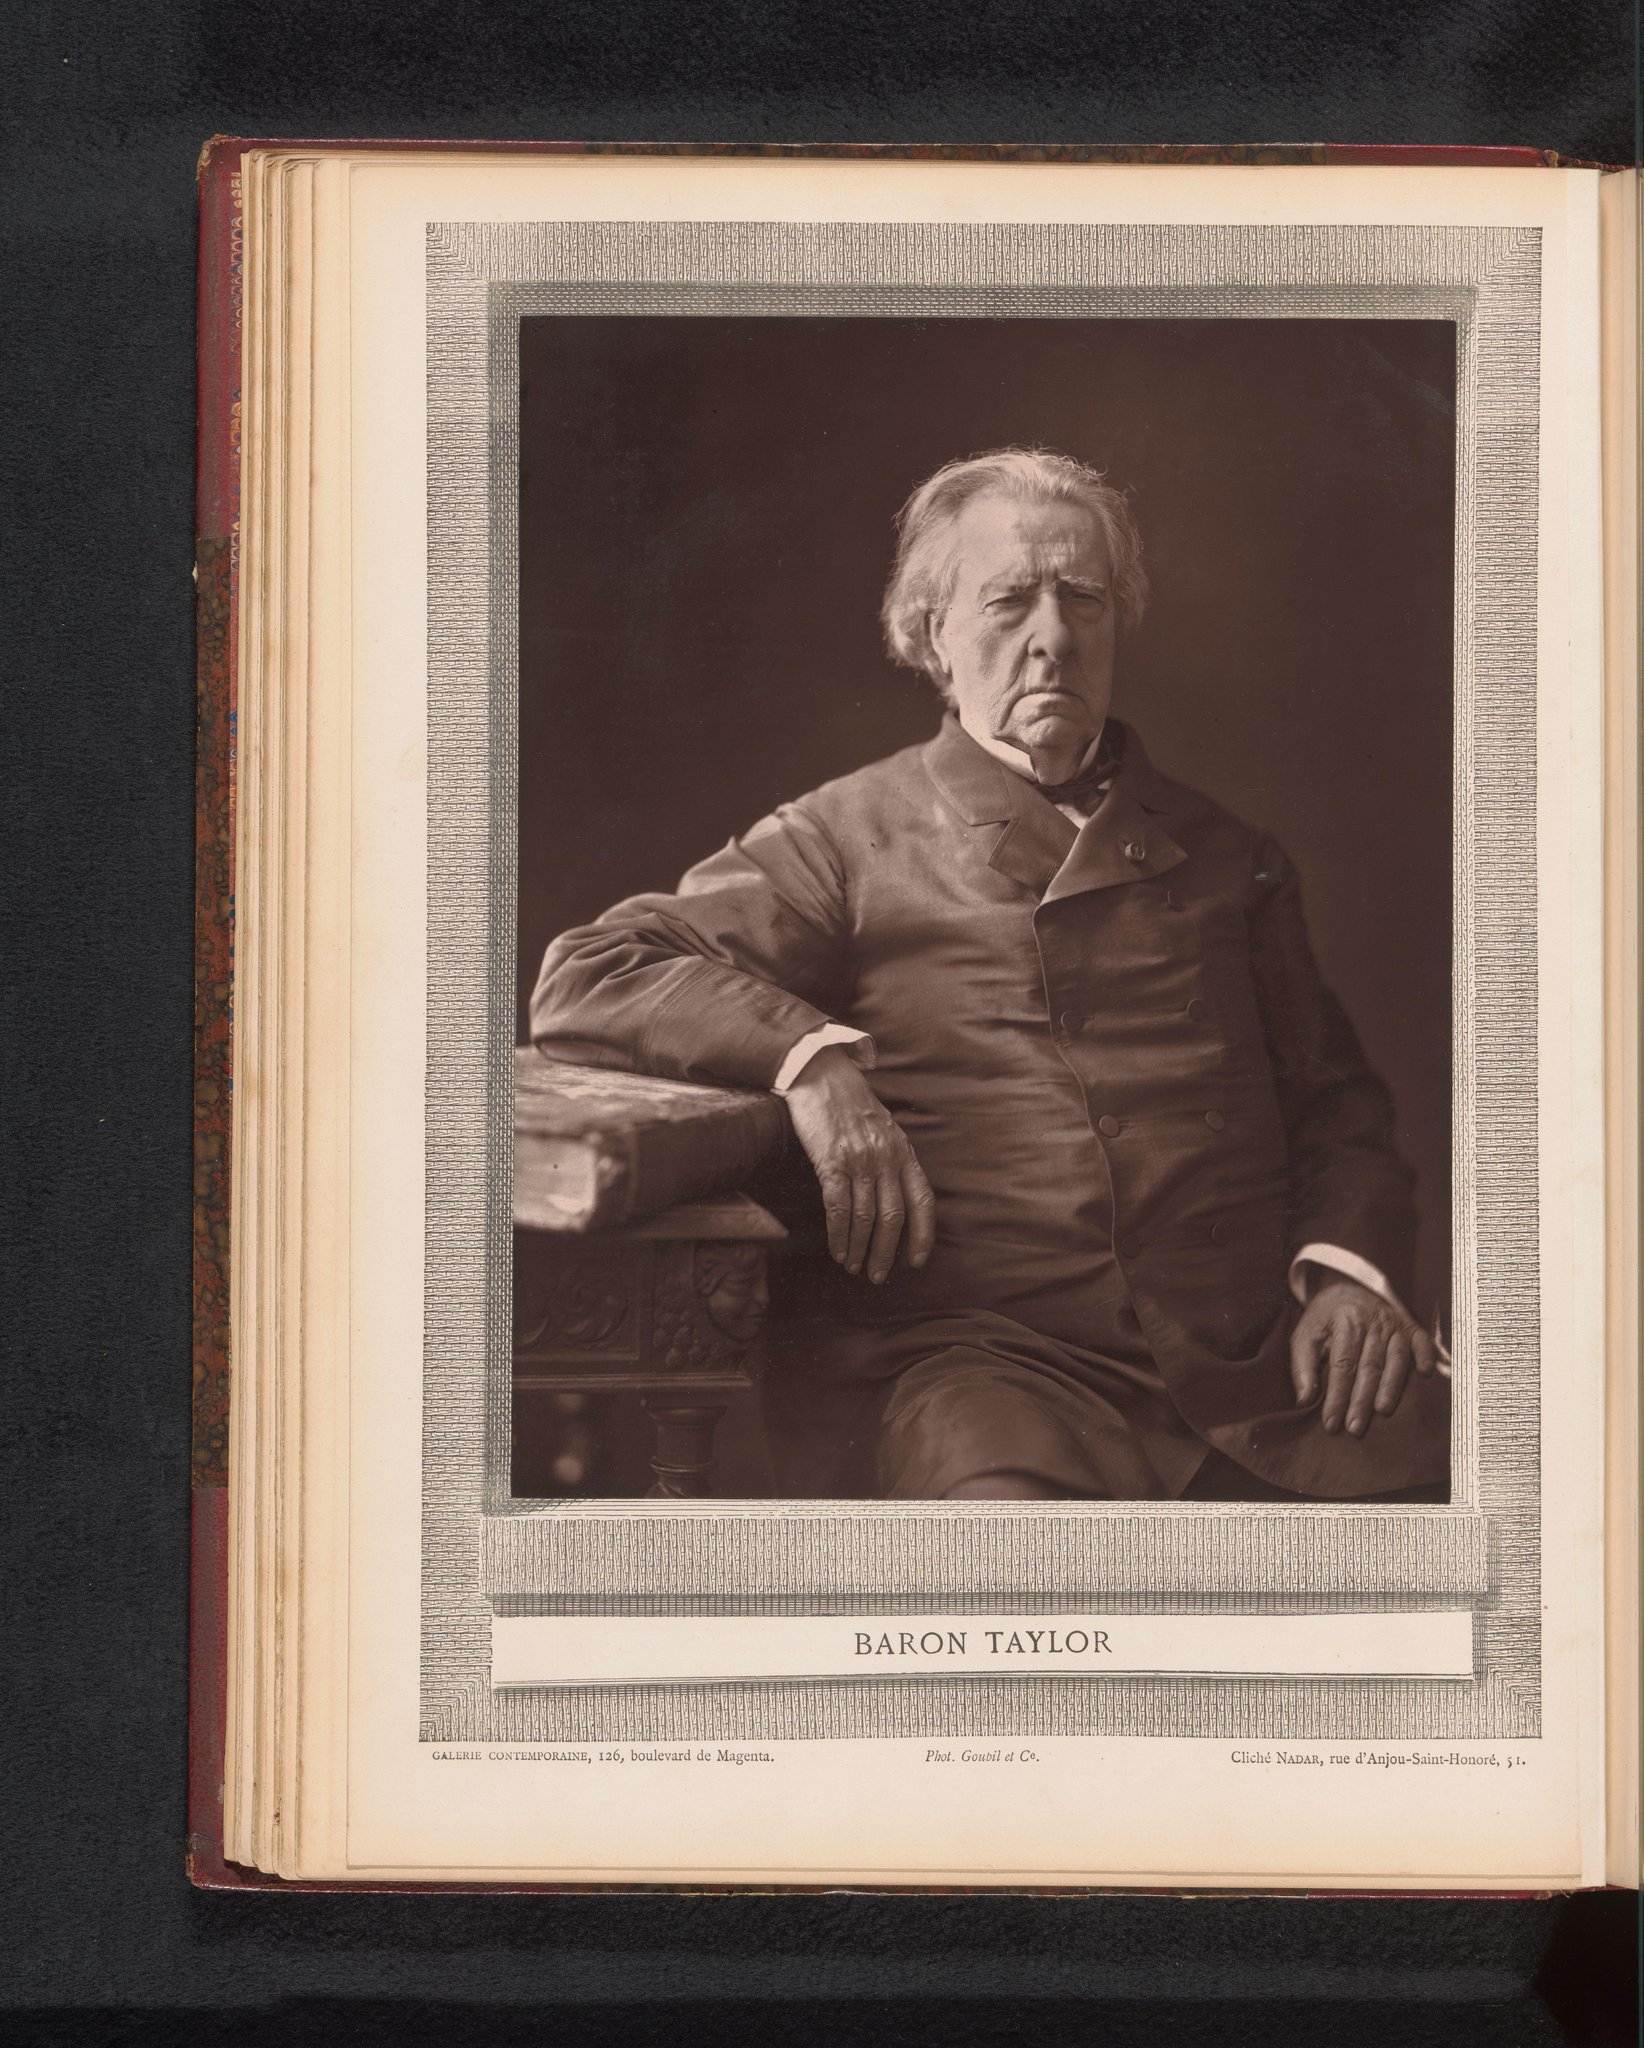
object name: page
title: Portret van Baron Isidore Justin Séverin Taylor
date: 1872-1877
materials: paper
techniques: woodburytype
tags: brussels, paris, politician, isidore justin séverin baron taylor, adult man, historical persons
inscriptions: inscription: ‘Galerie Contemporaine, 126, boulevard de Magenta.’